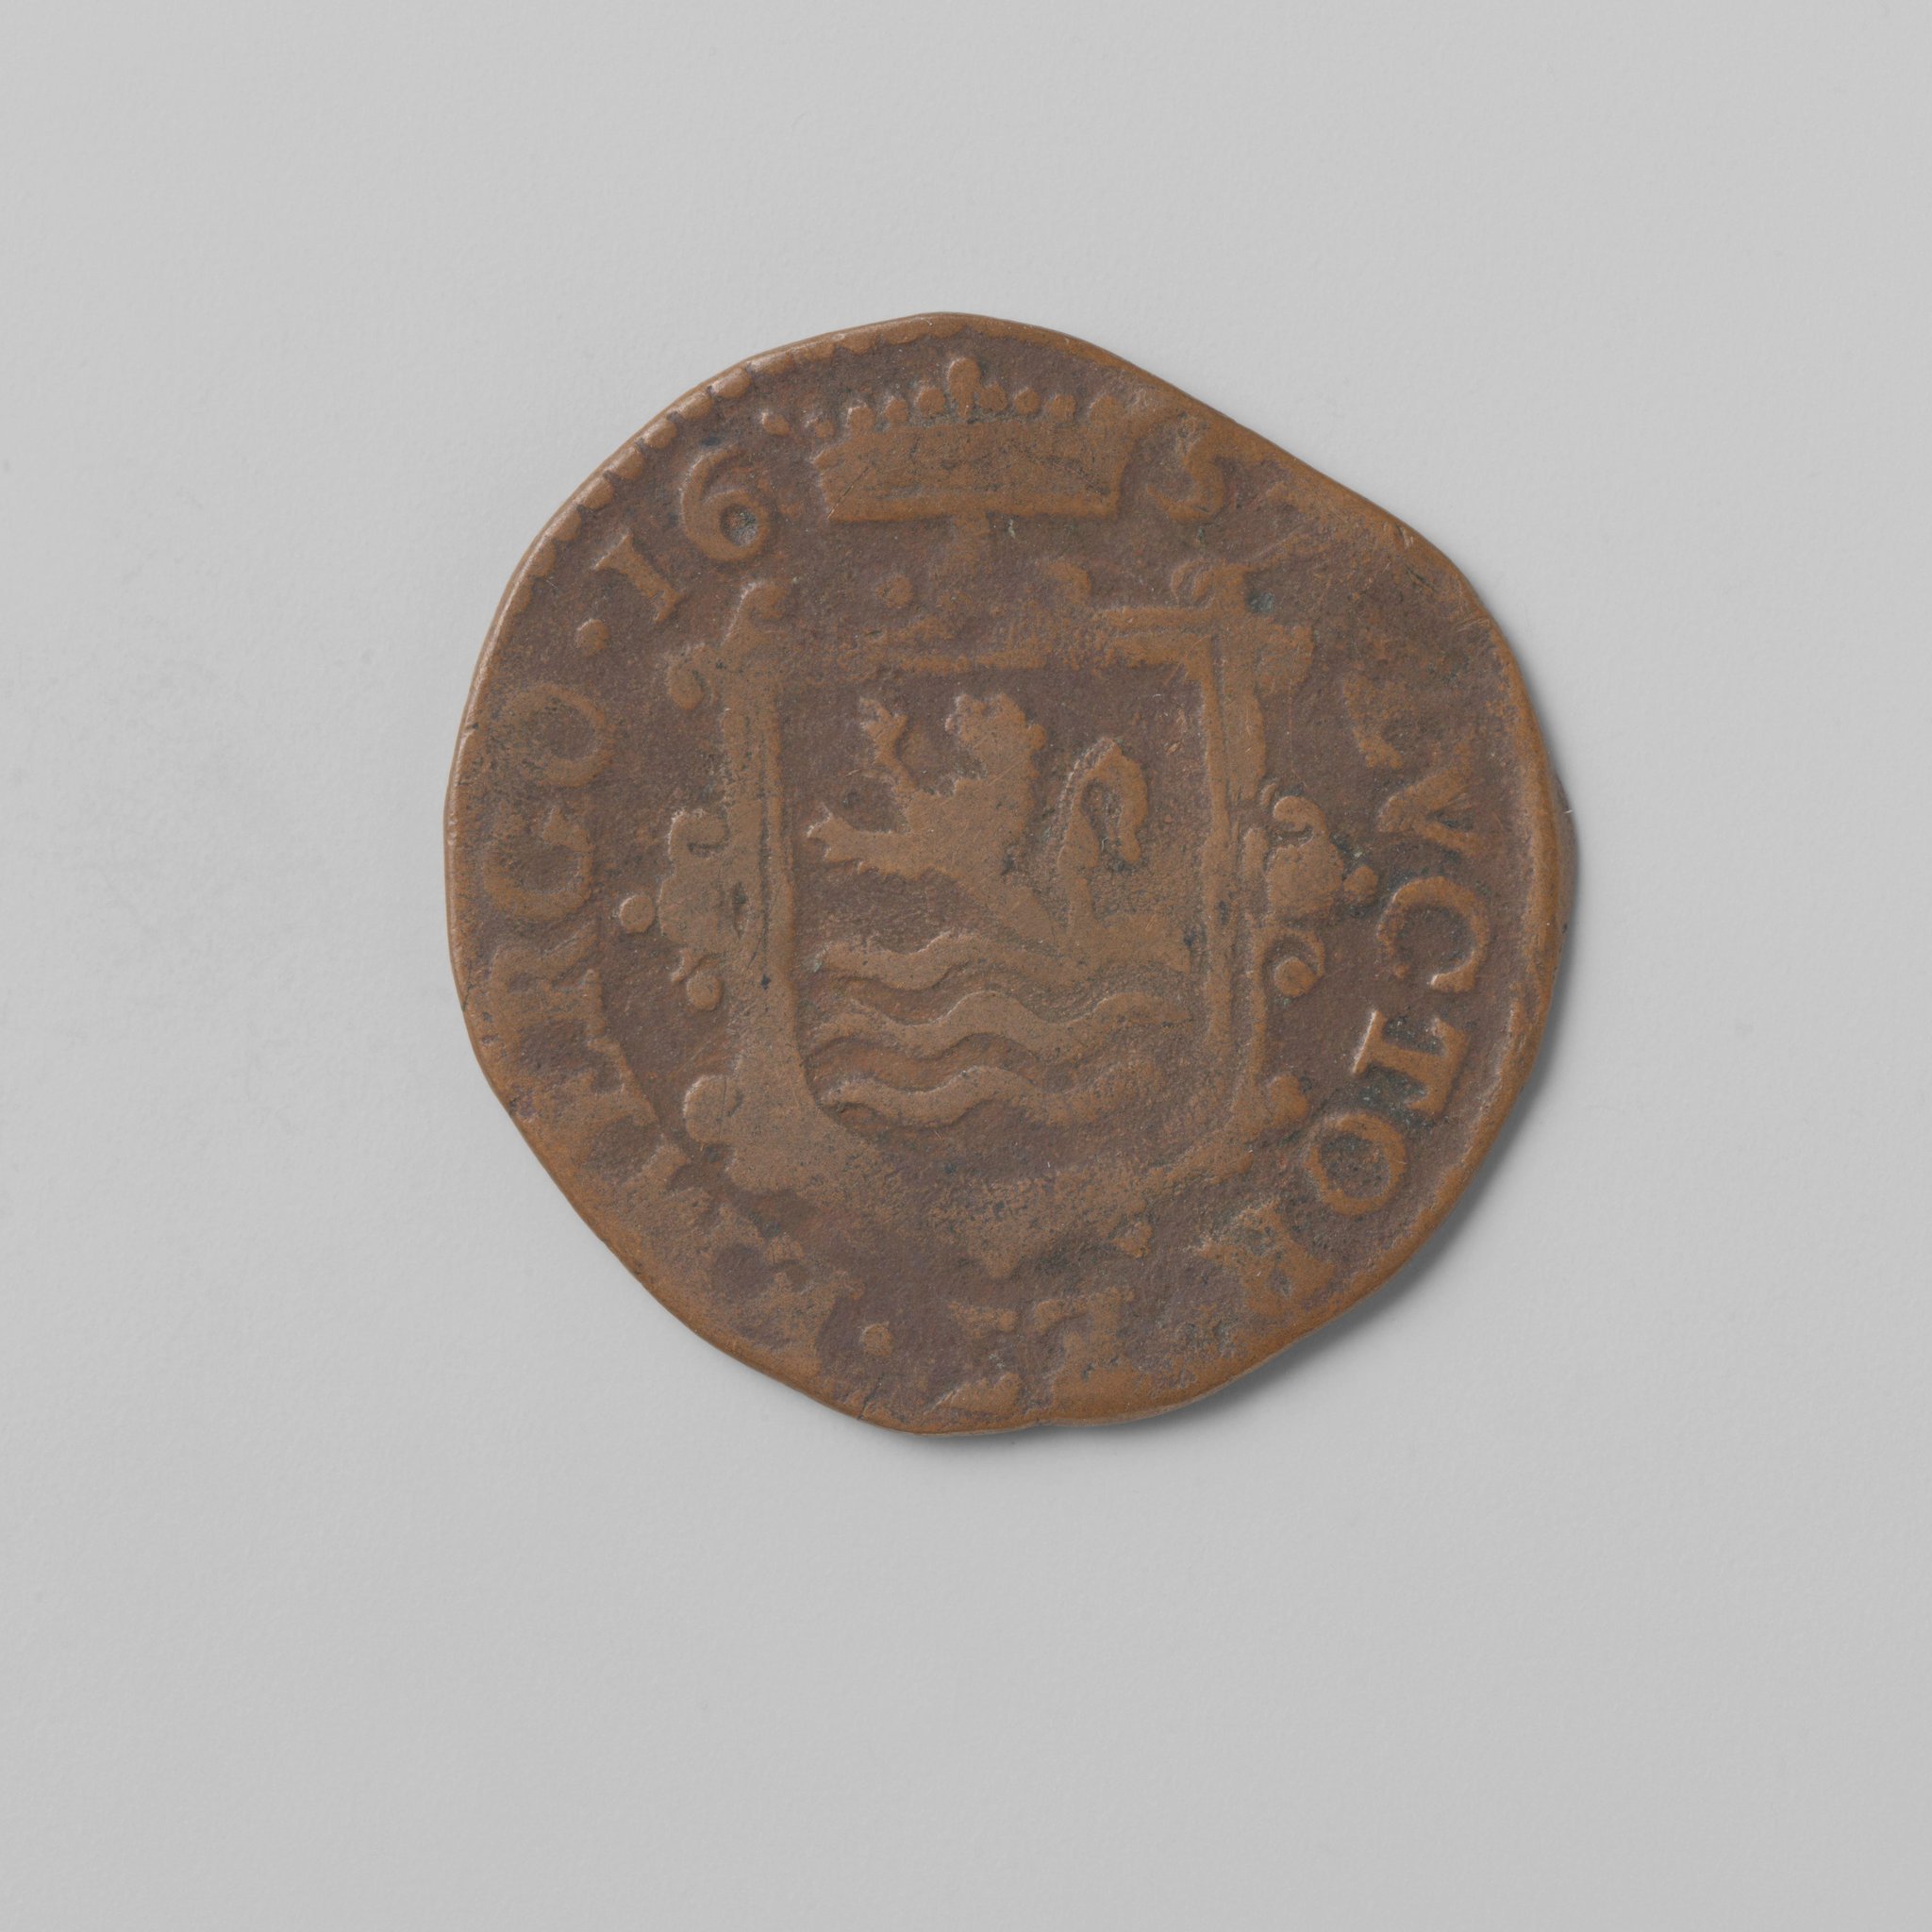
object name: oord, oortje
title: Zeeuwse oord, 1657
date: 1657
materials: copper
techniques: striking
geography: middelburg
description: Koperen munt. Voorzijde: borstbeeld van prins Maurits naar rechts. Keerzijde: gekroond wapenschild van Zeeland. Jaartal aan weerszijden van kroon.